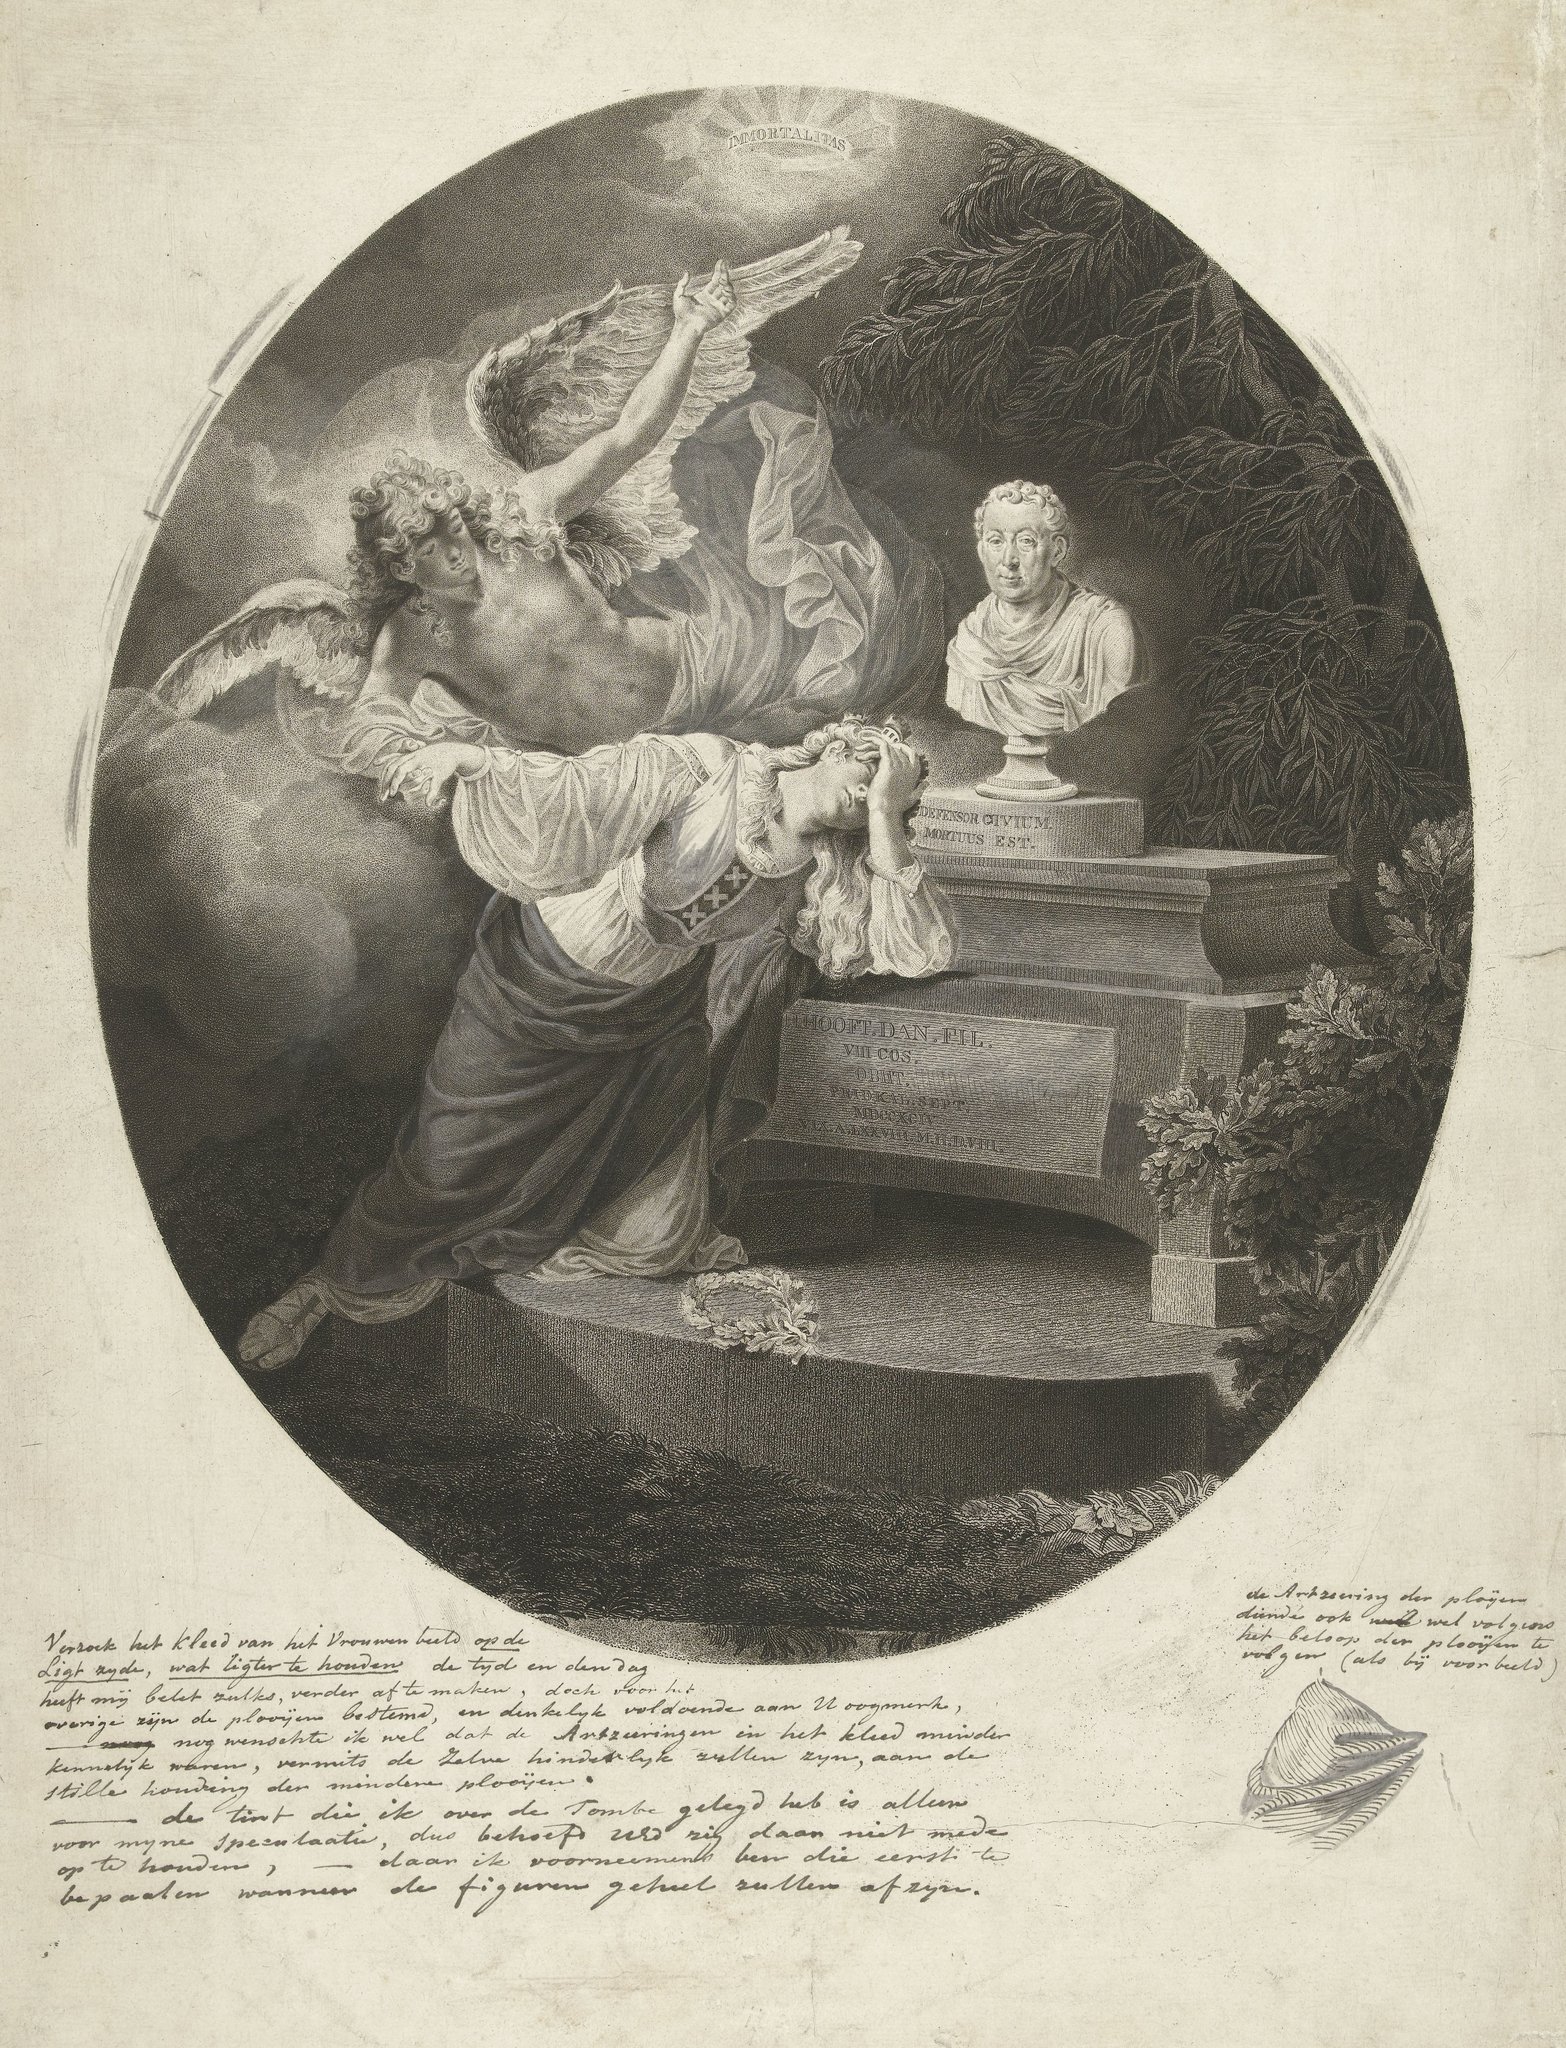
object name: print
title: Memorieprent voor Hendrik Hooft Daniëlsz.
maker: lambertus antonius claessens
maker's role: draughtsman, print maker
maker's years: 1763-1834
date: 1794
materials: paper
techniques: brush, etching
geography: amsterdam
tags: mayor, hendrik danielsz. hooft, personification of a city, town-patron(ess), grave, tomb, amsterdam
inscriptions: collector's mark: Lugt 2228, inscription: ‘Verzoek het kleed van het Vrouwenbeeld op de Ligt zyde, wat ligter te houden de tyd van den dag heeft mij belet zulks, verder af te maken ...’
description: De Amsterdamse stedenmaagd rouwt bij het graf van de Amsterdamse burgermeester Hendrik Hooft Daniëlsz. Een engel steunt haar in het verdriet en wijst haar op de onsterfelijkheid van de overledene. Op de graftombe staat een portretbuste van Hooft Daniëlsz. in antieke stijl.